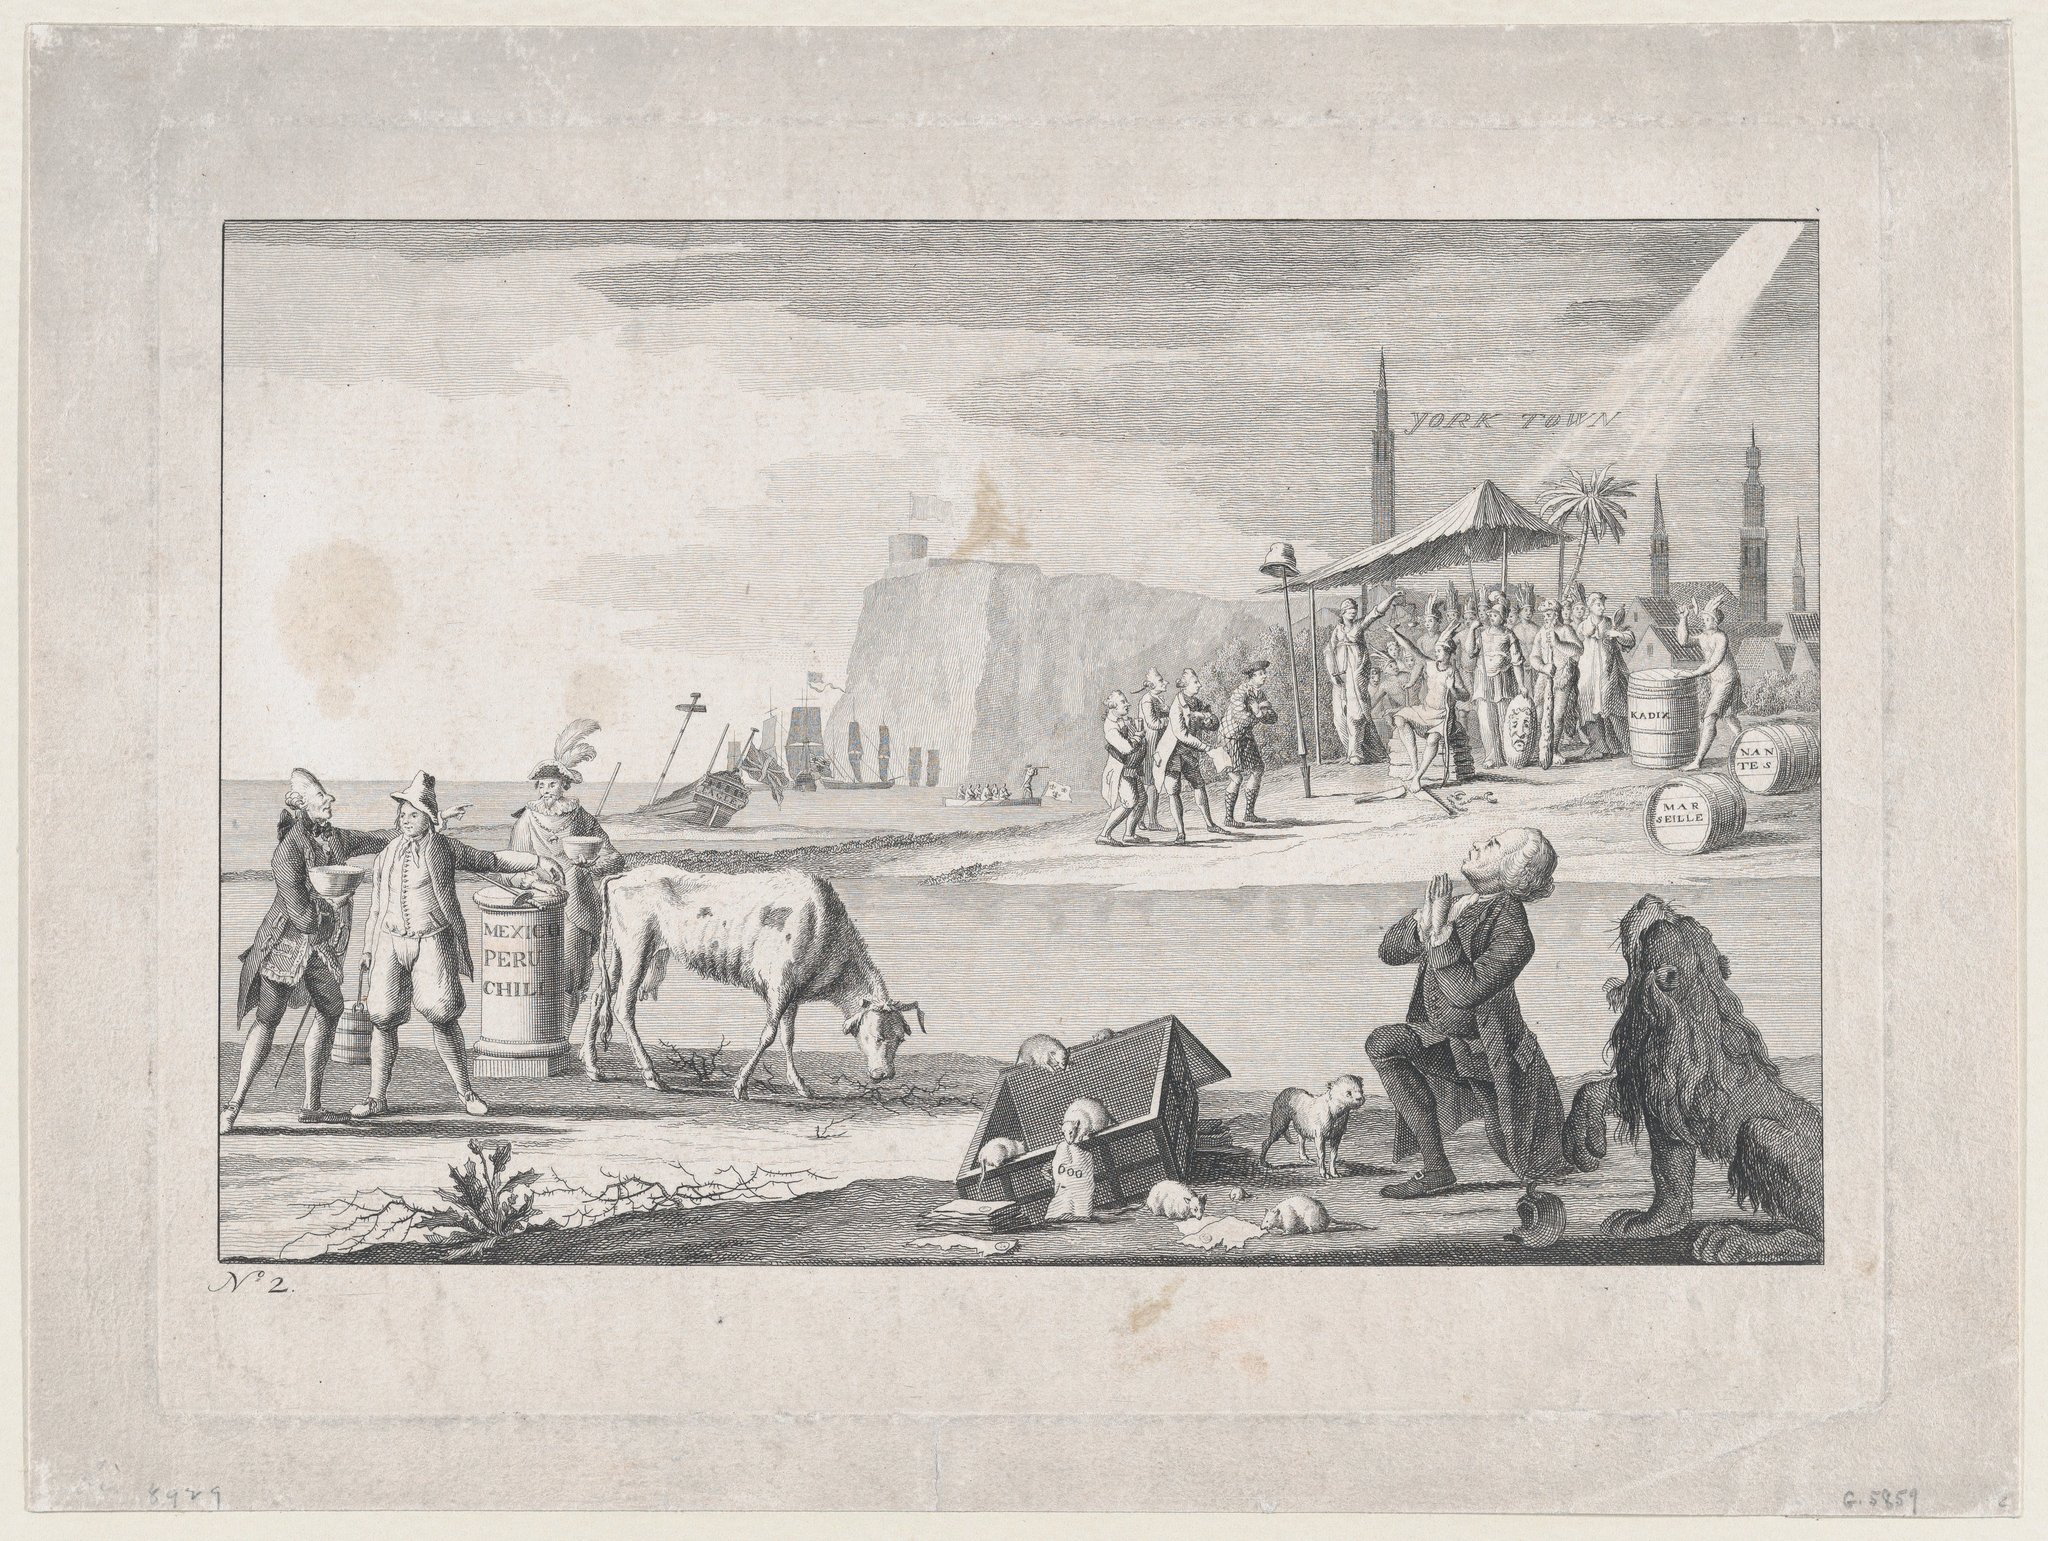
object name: print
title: Yorktown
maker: anonymous, dutch, 18th century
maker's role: artist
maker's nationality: dutch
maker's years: 1700-1800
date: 1781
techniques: engraving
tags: satire,american revolution,men,cows,lions